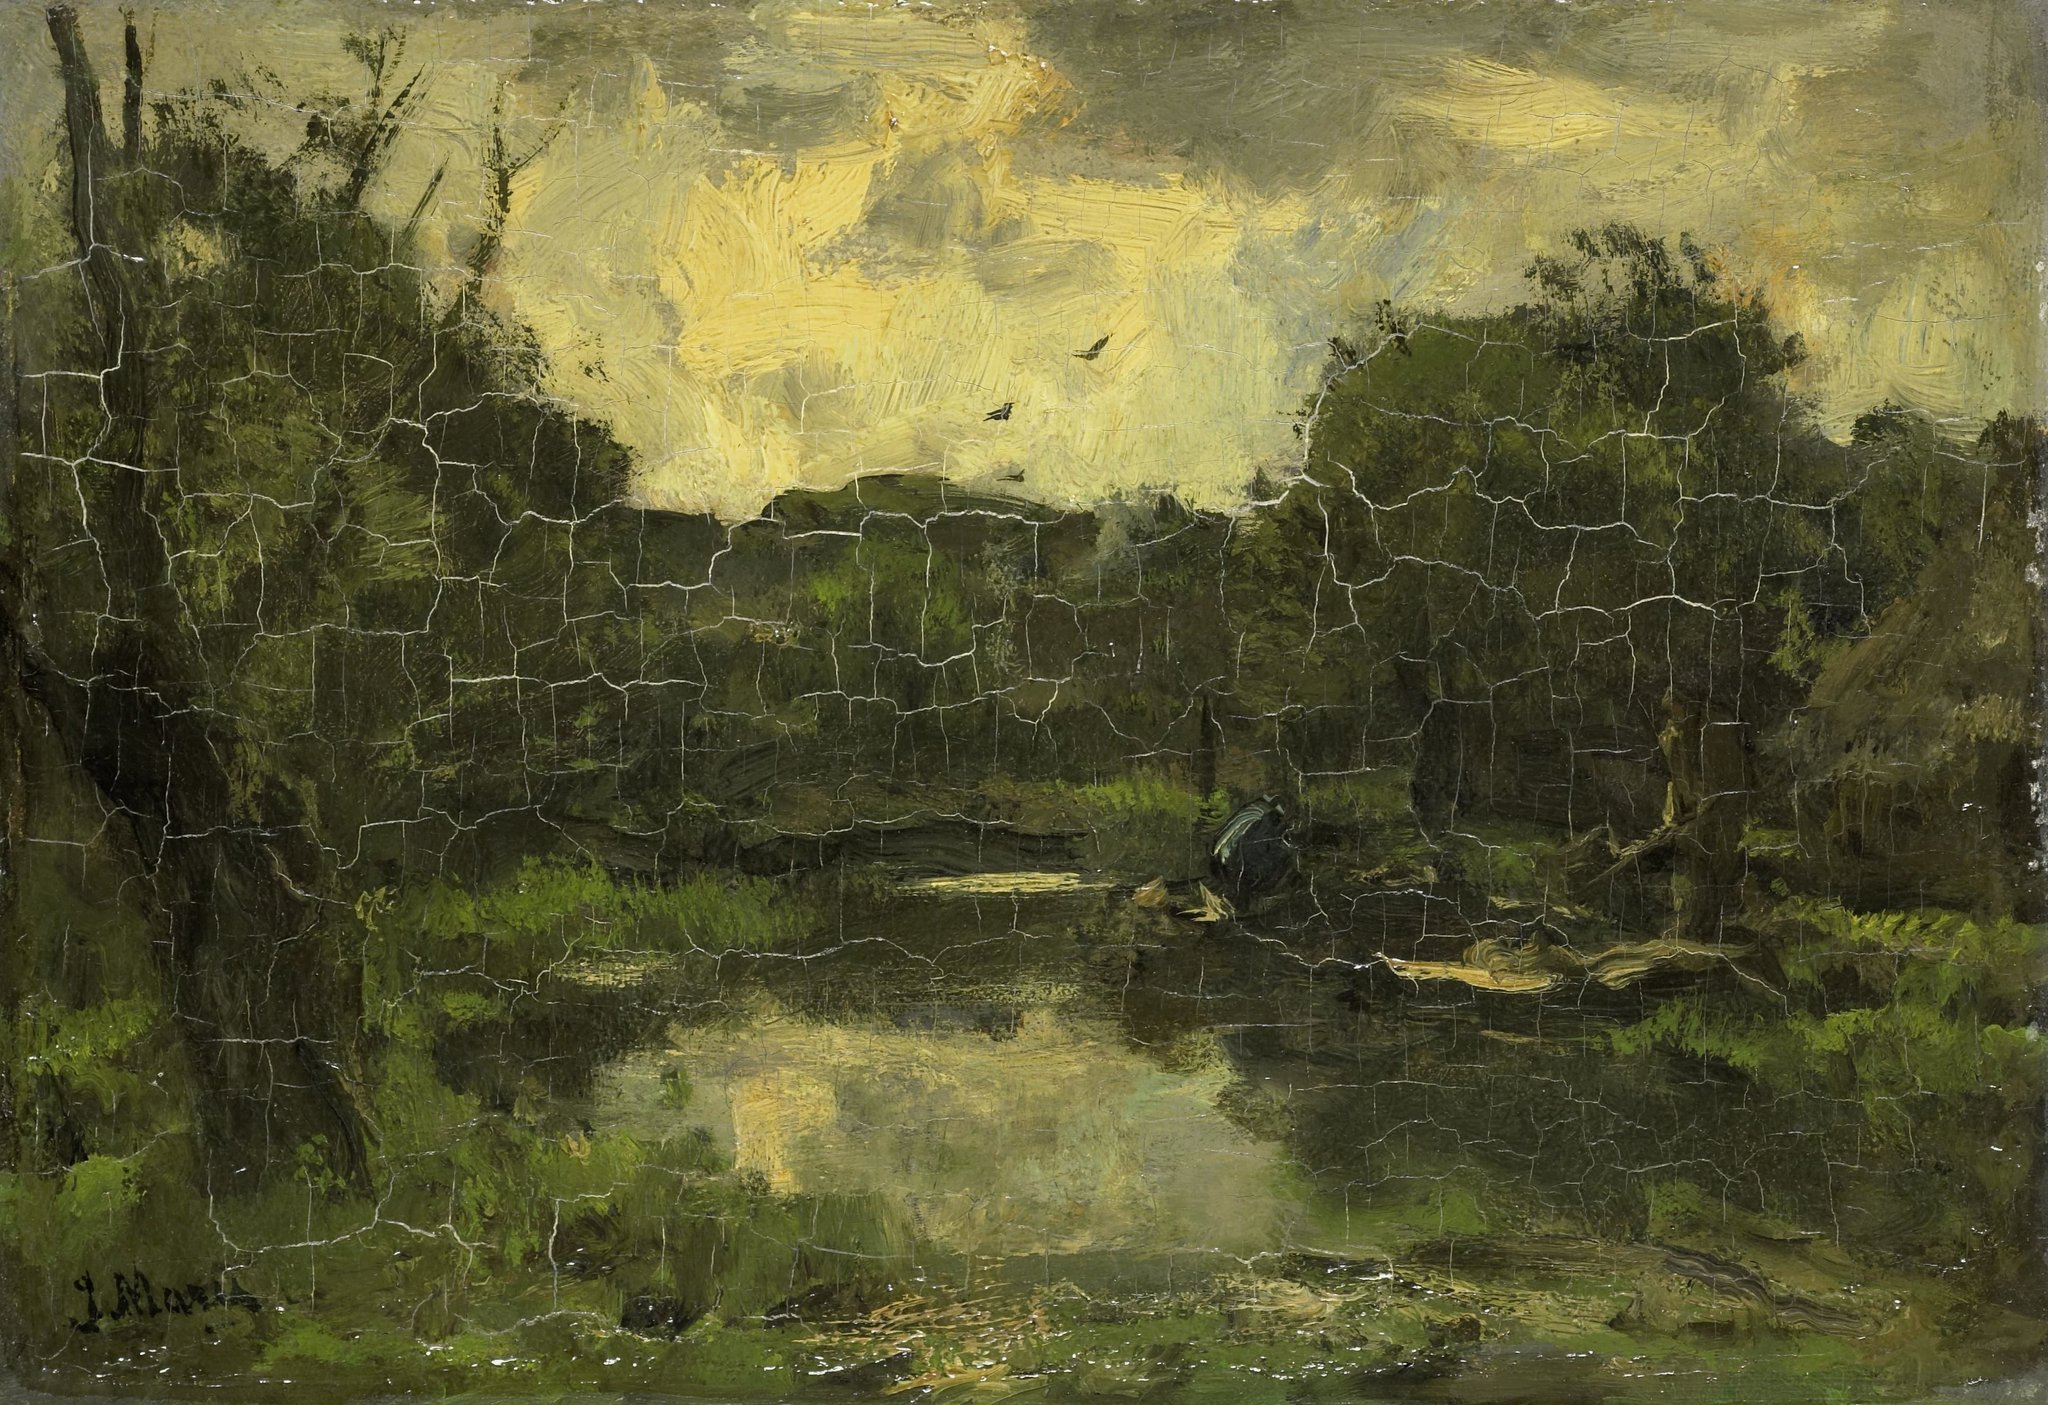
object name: painting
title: Landschap met schuit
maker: jacob maris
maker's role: draughtsman, painter, print maker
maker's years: 1837-1899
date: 1886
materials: oil, panel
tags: water course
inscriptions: signature: ‘J Maris’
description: Landschap met een schuit op het water. Langs de oevers struikgewas en enkele knotwilgen.